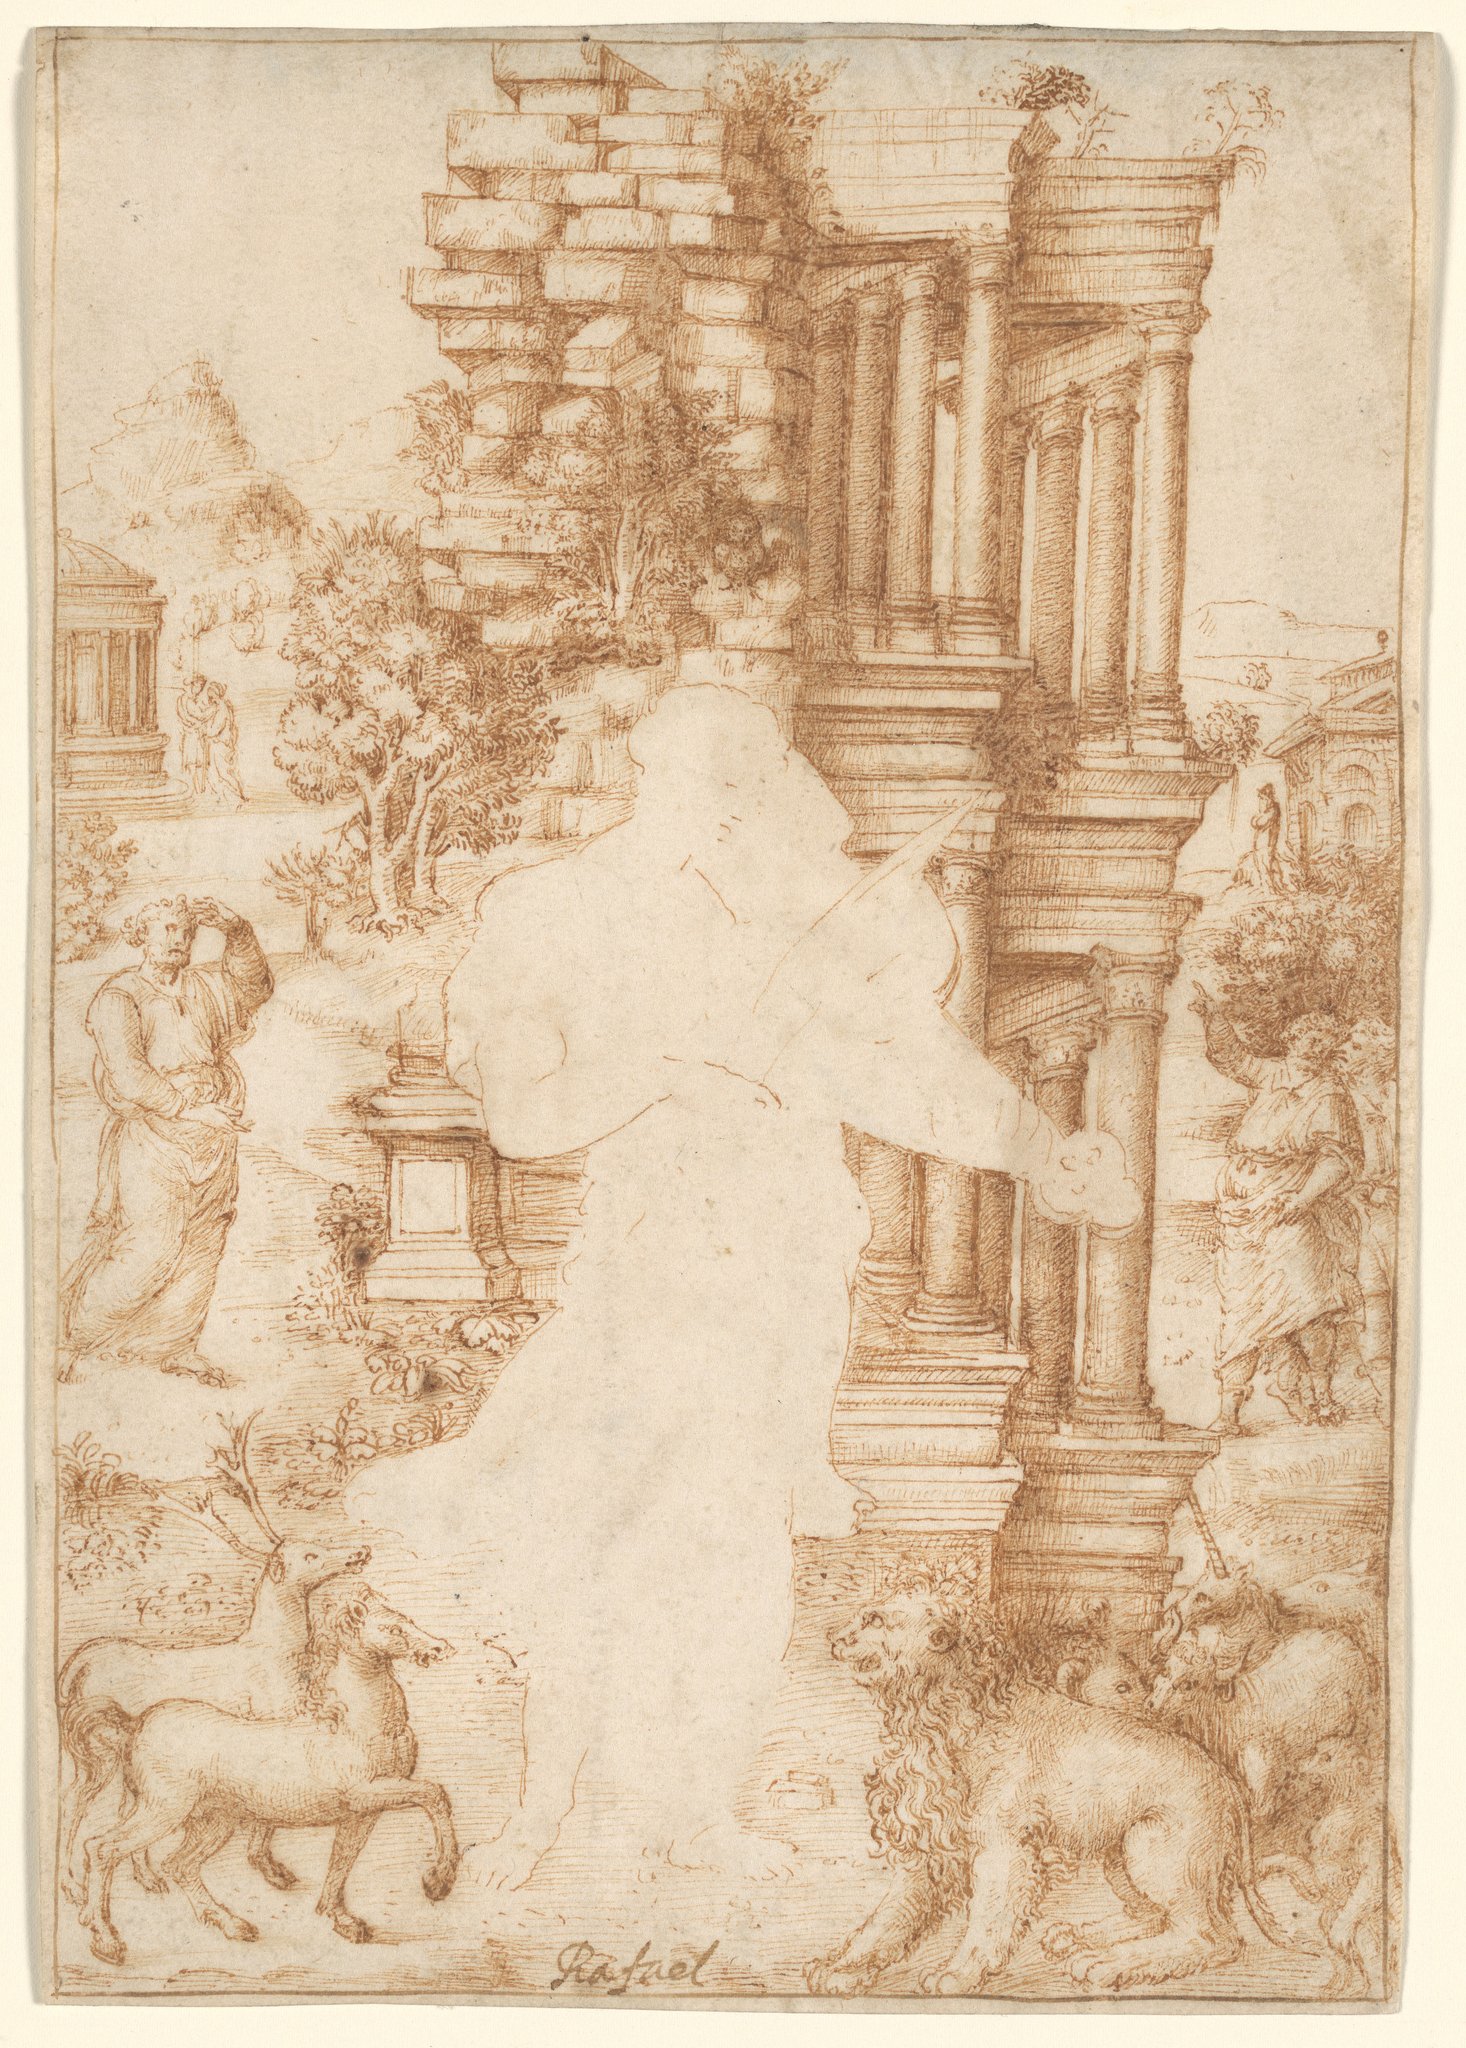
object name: drawing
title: Orpheus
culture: central italian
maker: italian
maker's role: artist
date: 1501-1533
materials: ink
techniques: pen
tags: musical instruments,orpheus,deer,lions